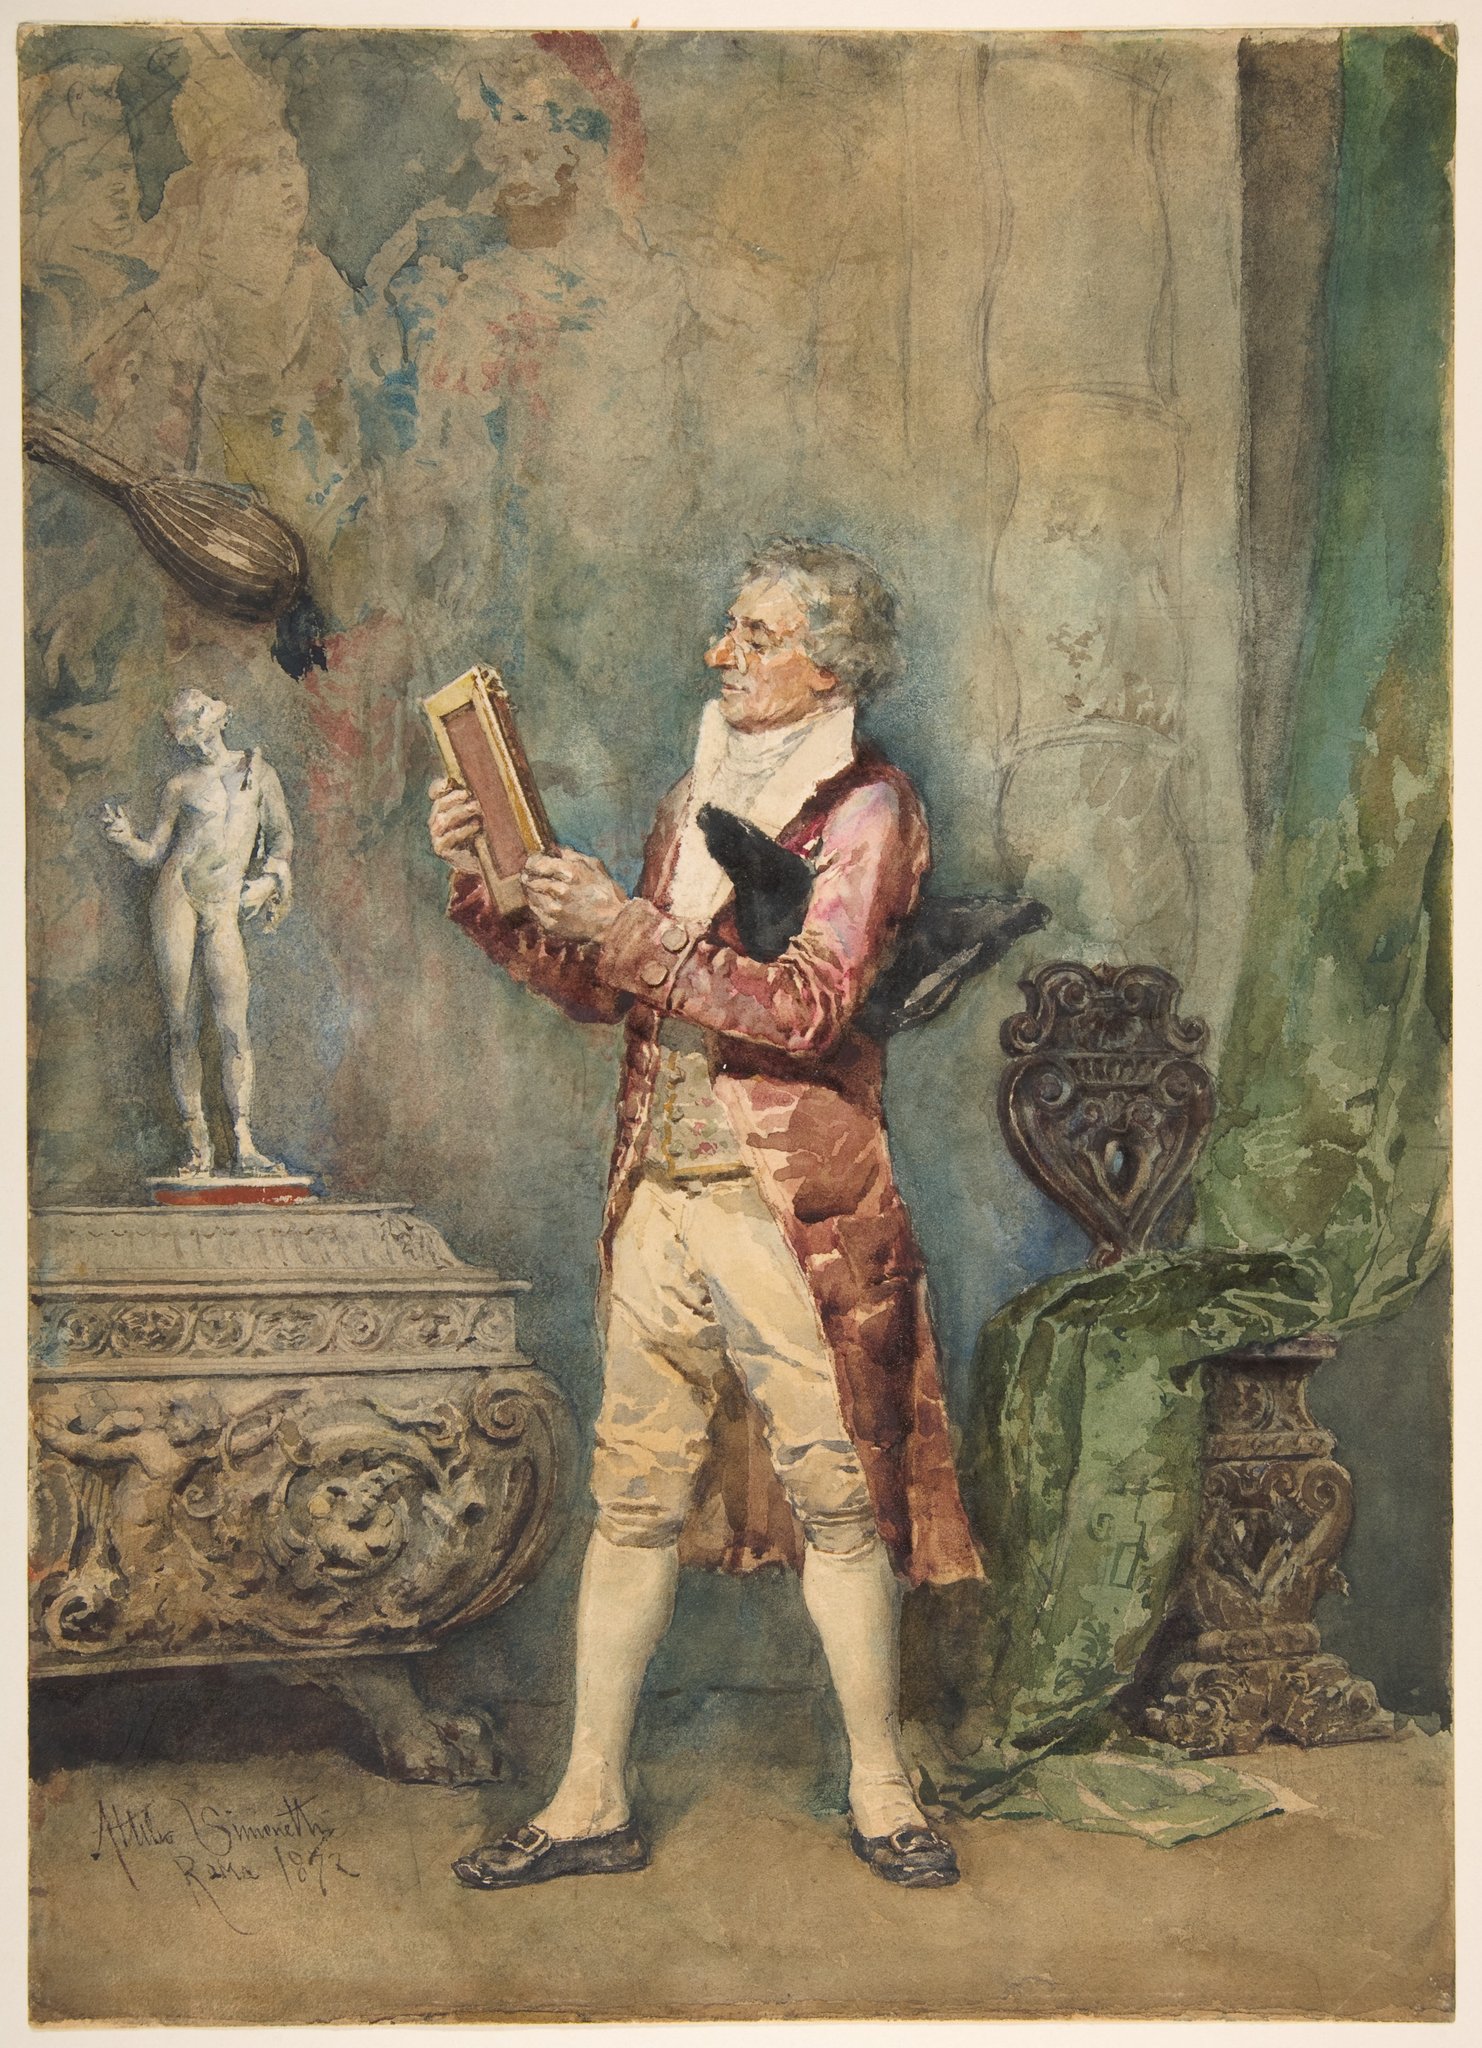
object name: drawing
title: The Amateur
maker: attilio simonetti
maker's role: artist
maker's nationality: italian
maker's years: 1843-1925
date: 1843-1925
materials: watercolor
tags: sculpture,men,chairs